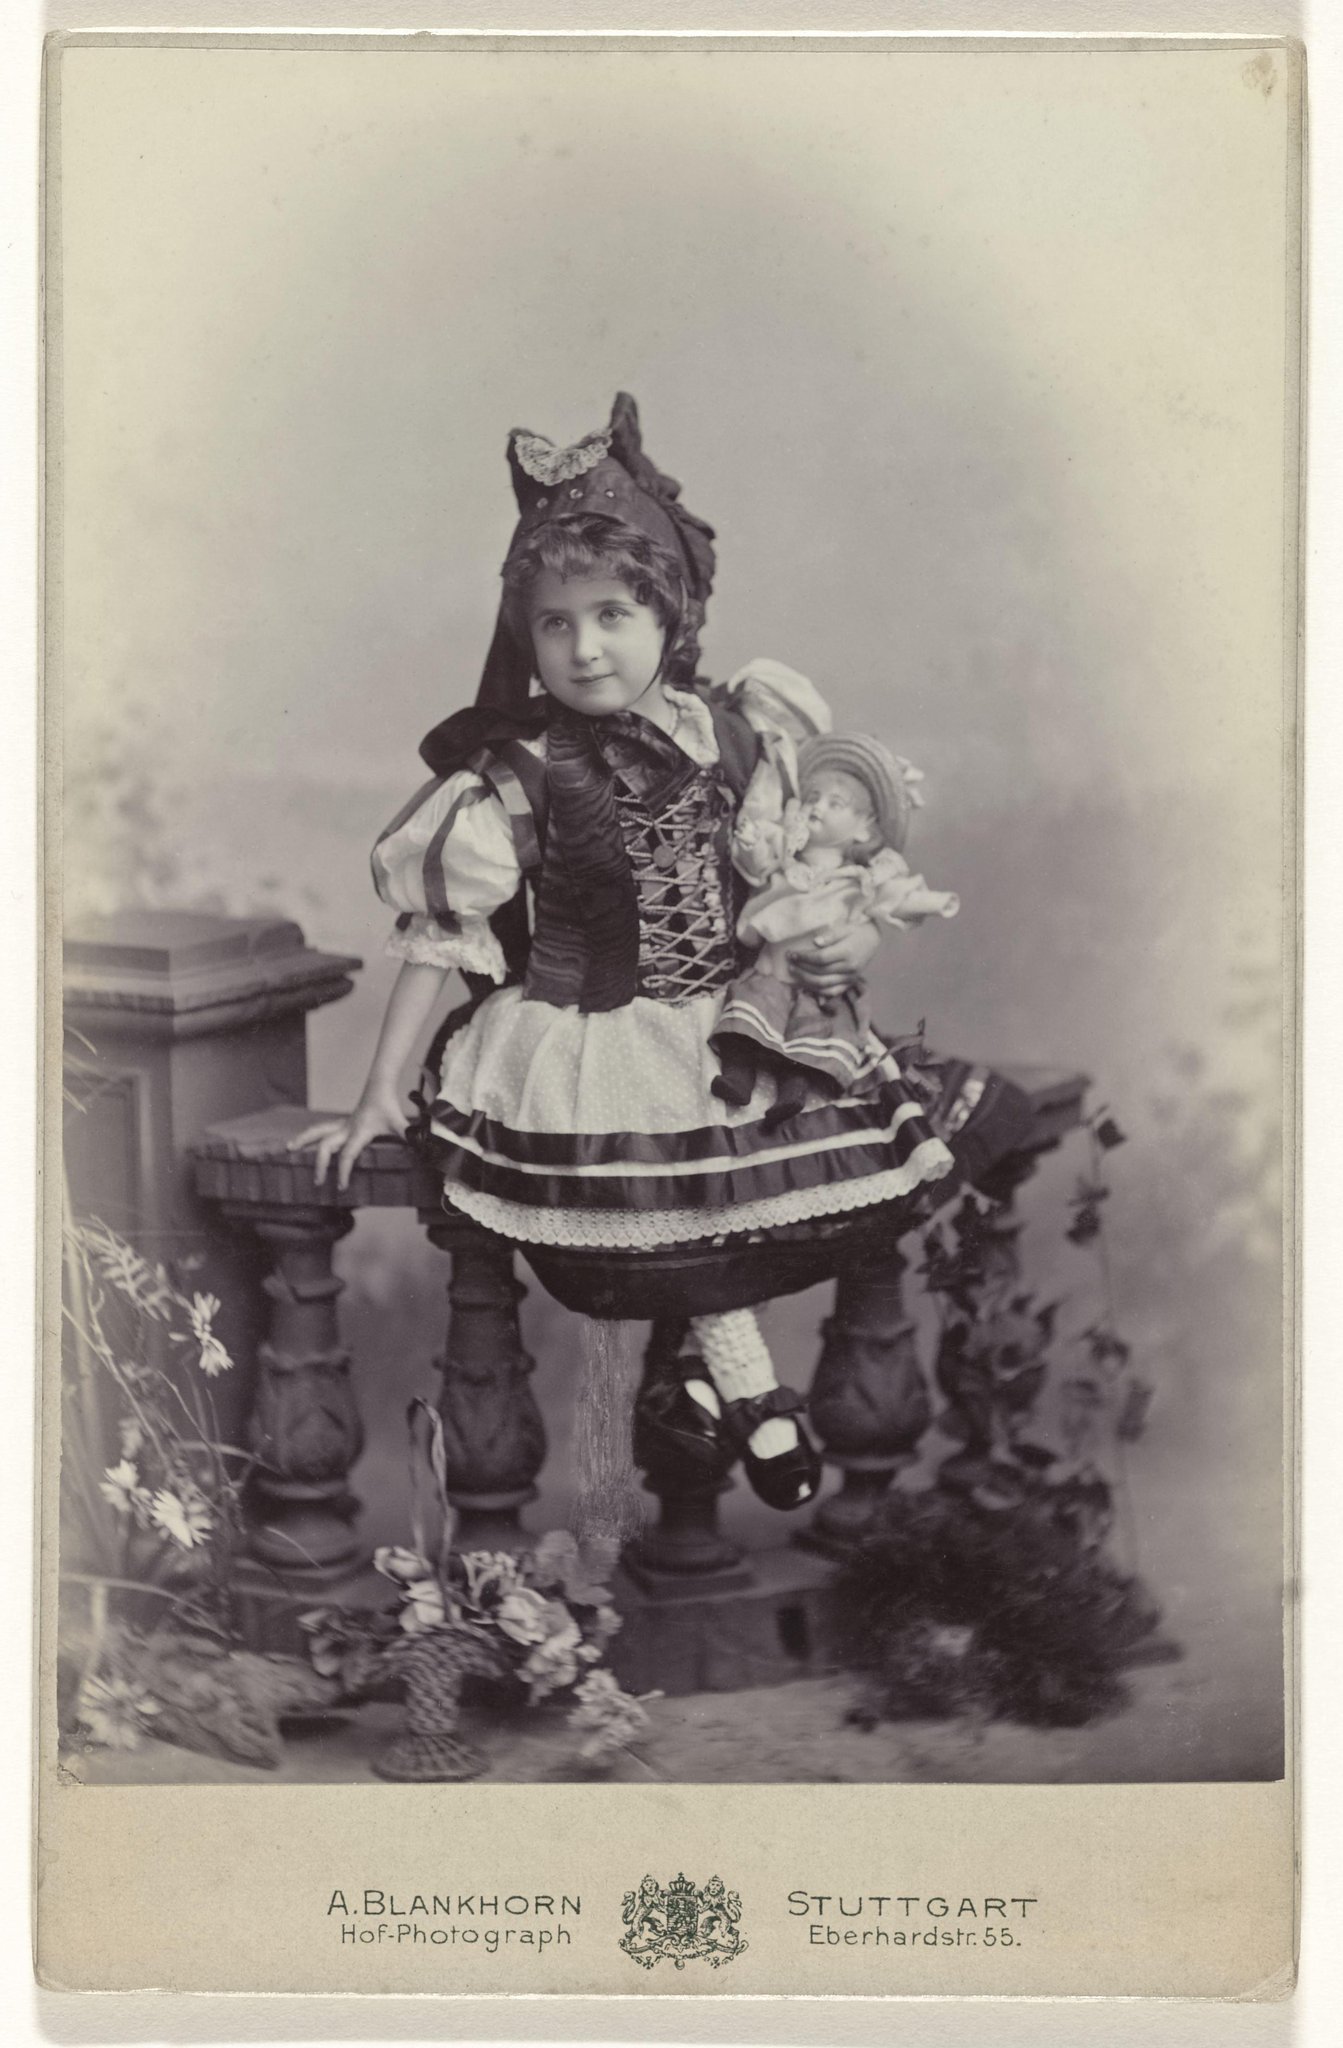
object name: photograph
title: Else Wachenheimer-Moos als kind in zuid-Duitse klederdracht, gezeten op een balustrade met een pop in haar armen, gemaakt rondom carnaval in februari 1899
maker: a. blankhorn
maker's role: fotograaf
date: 1899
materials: photographic support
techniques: gelatin silver print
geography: stuttgart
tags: else wachenheimer-moos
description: Else Wachenheimer-Moos in zuid-Duitse klederdracht, gezeten op een balustrade met een pop in haar armen.